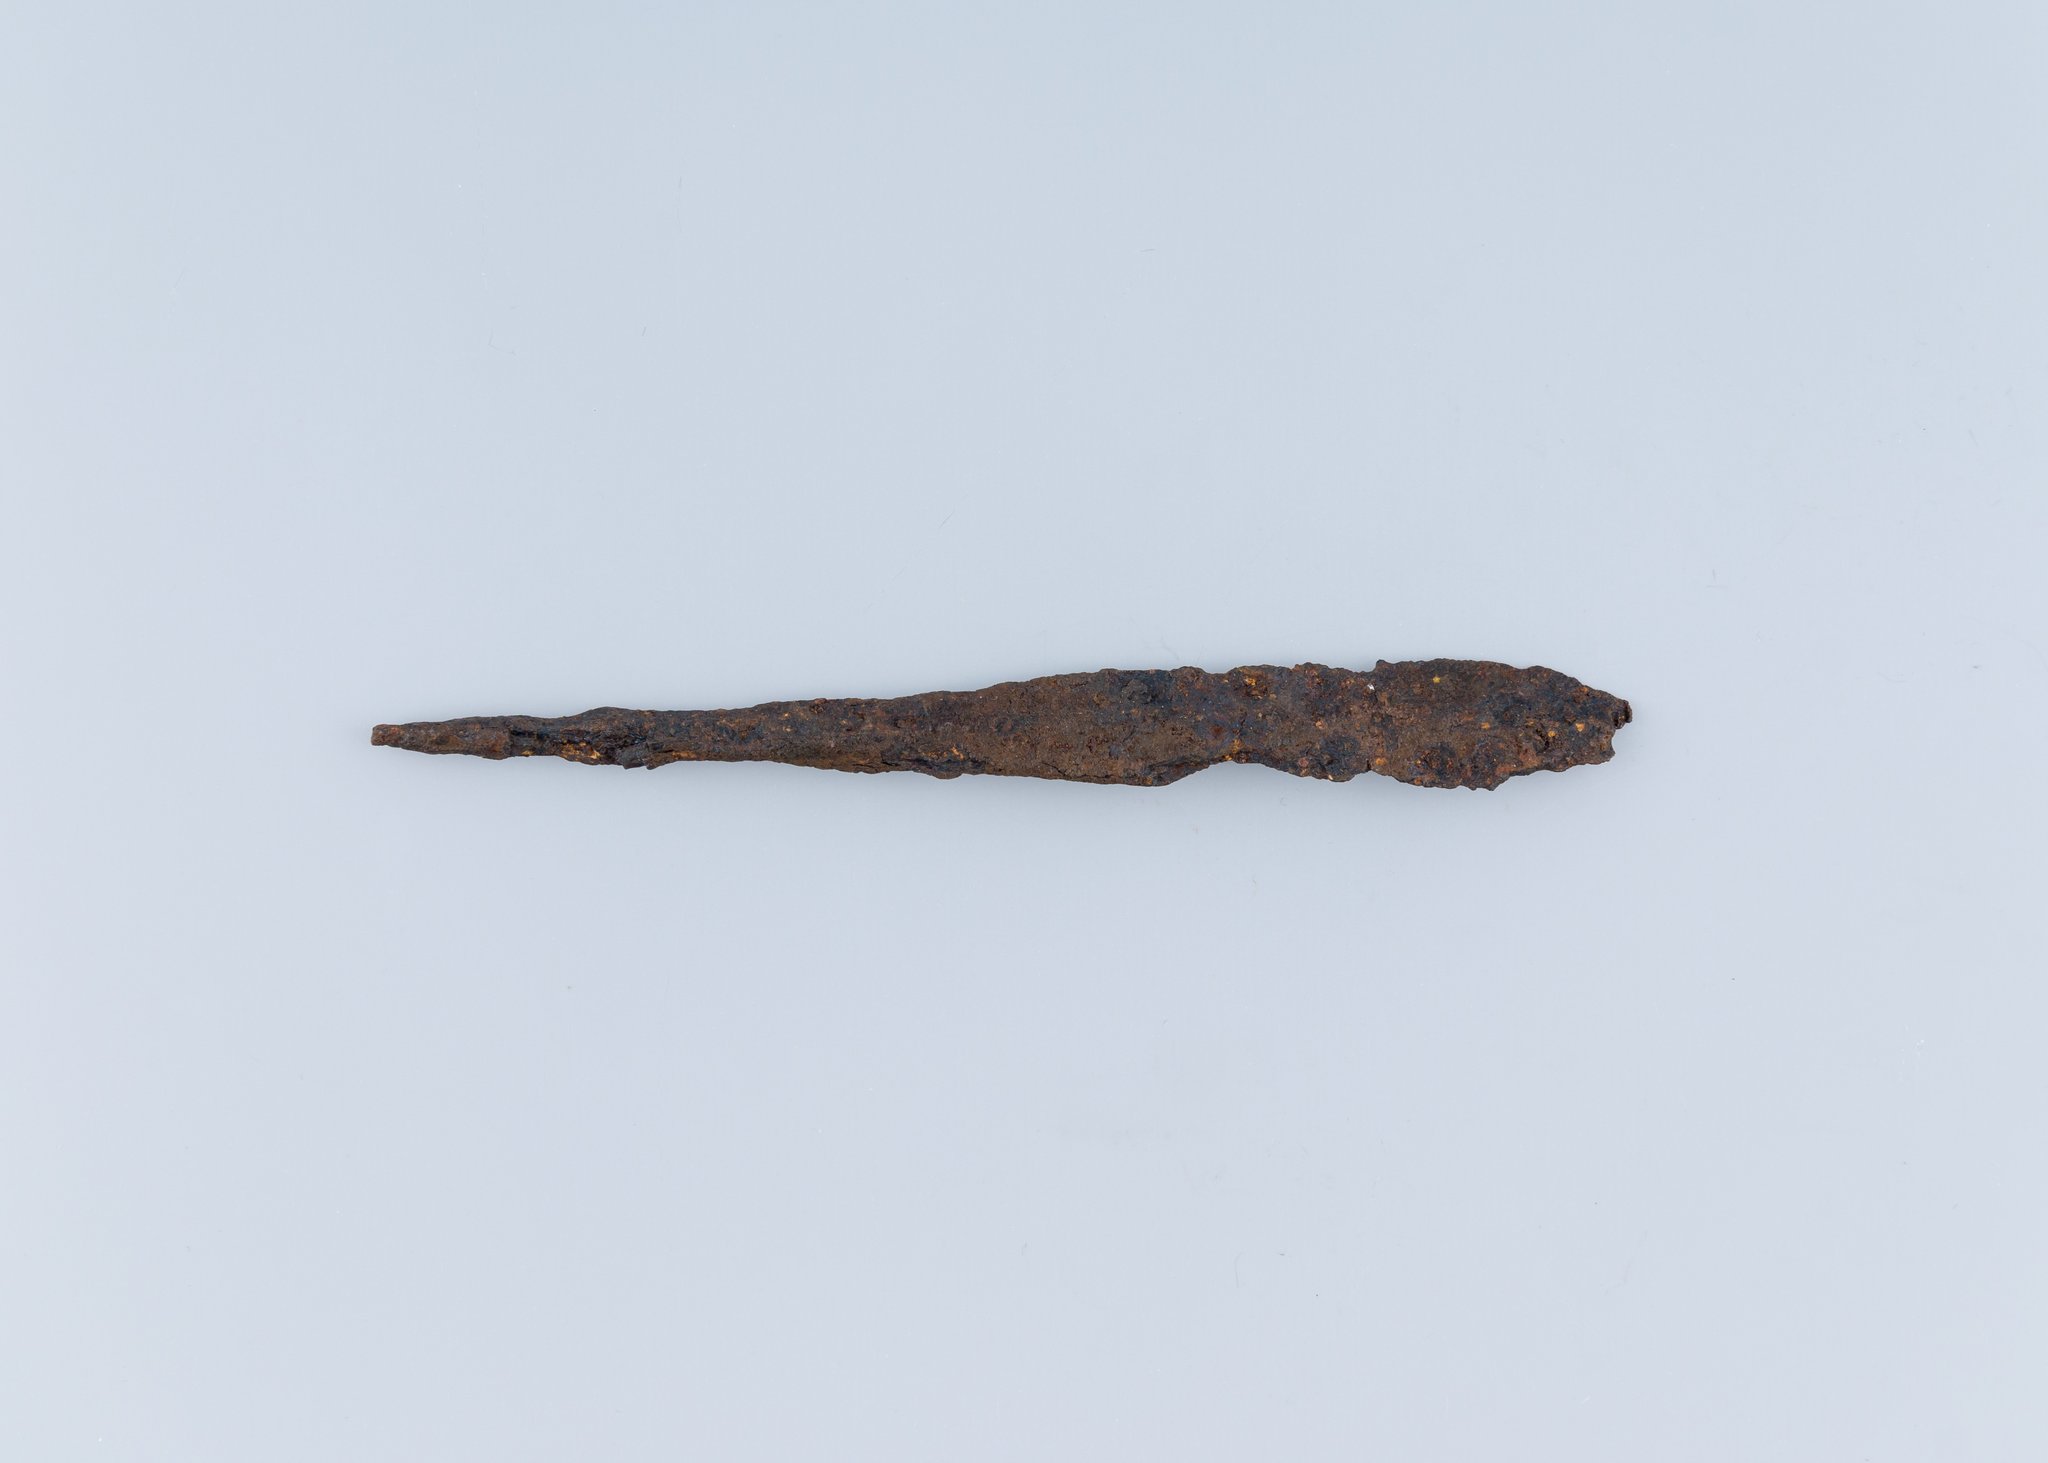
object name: five arrowhead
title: Five Arrowheads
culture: norwegian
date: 800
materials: iron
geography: norway